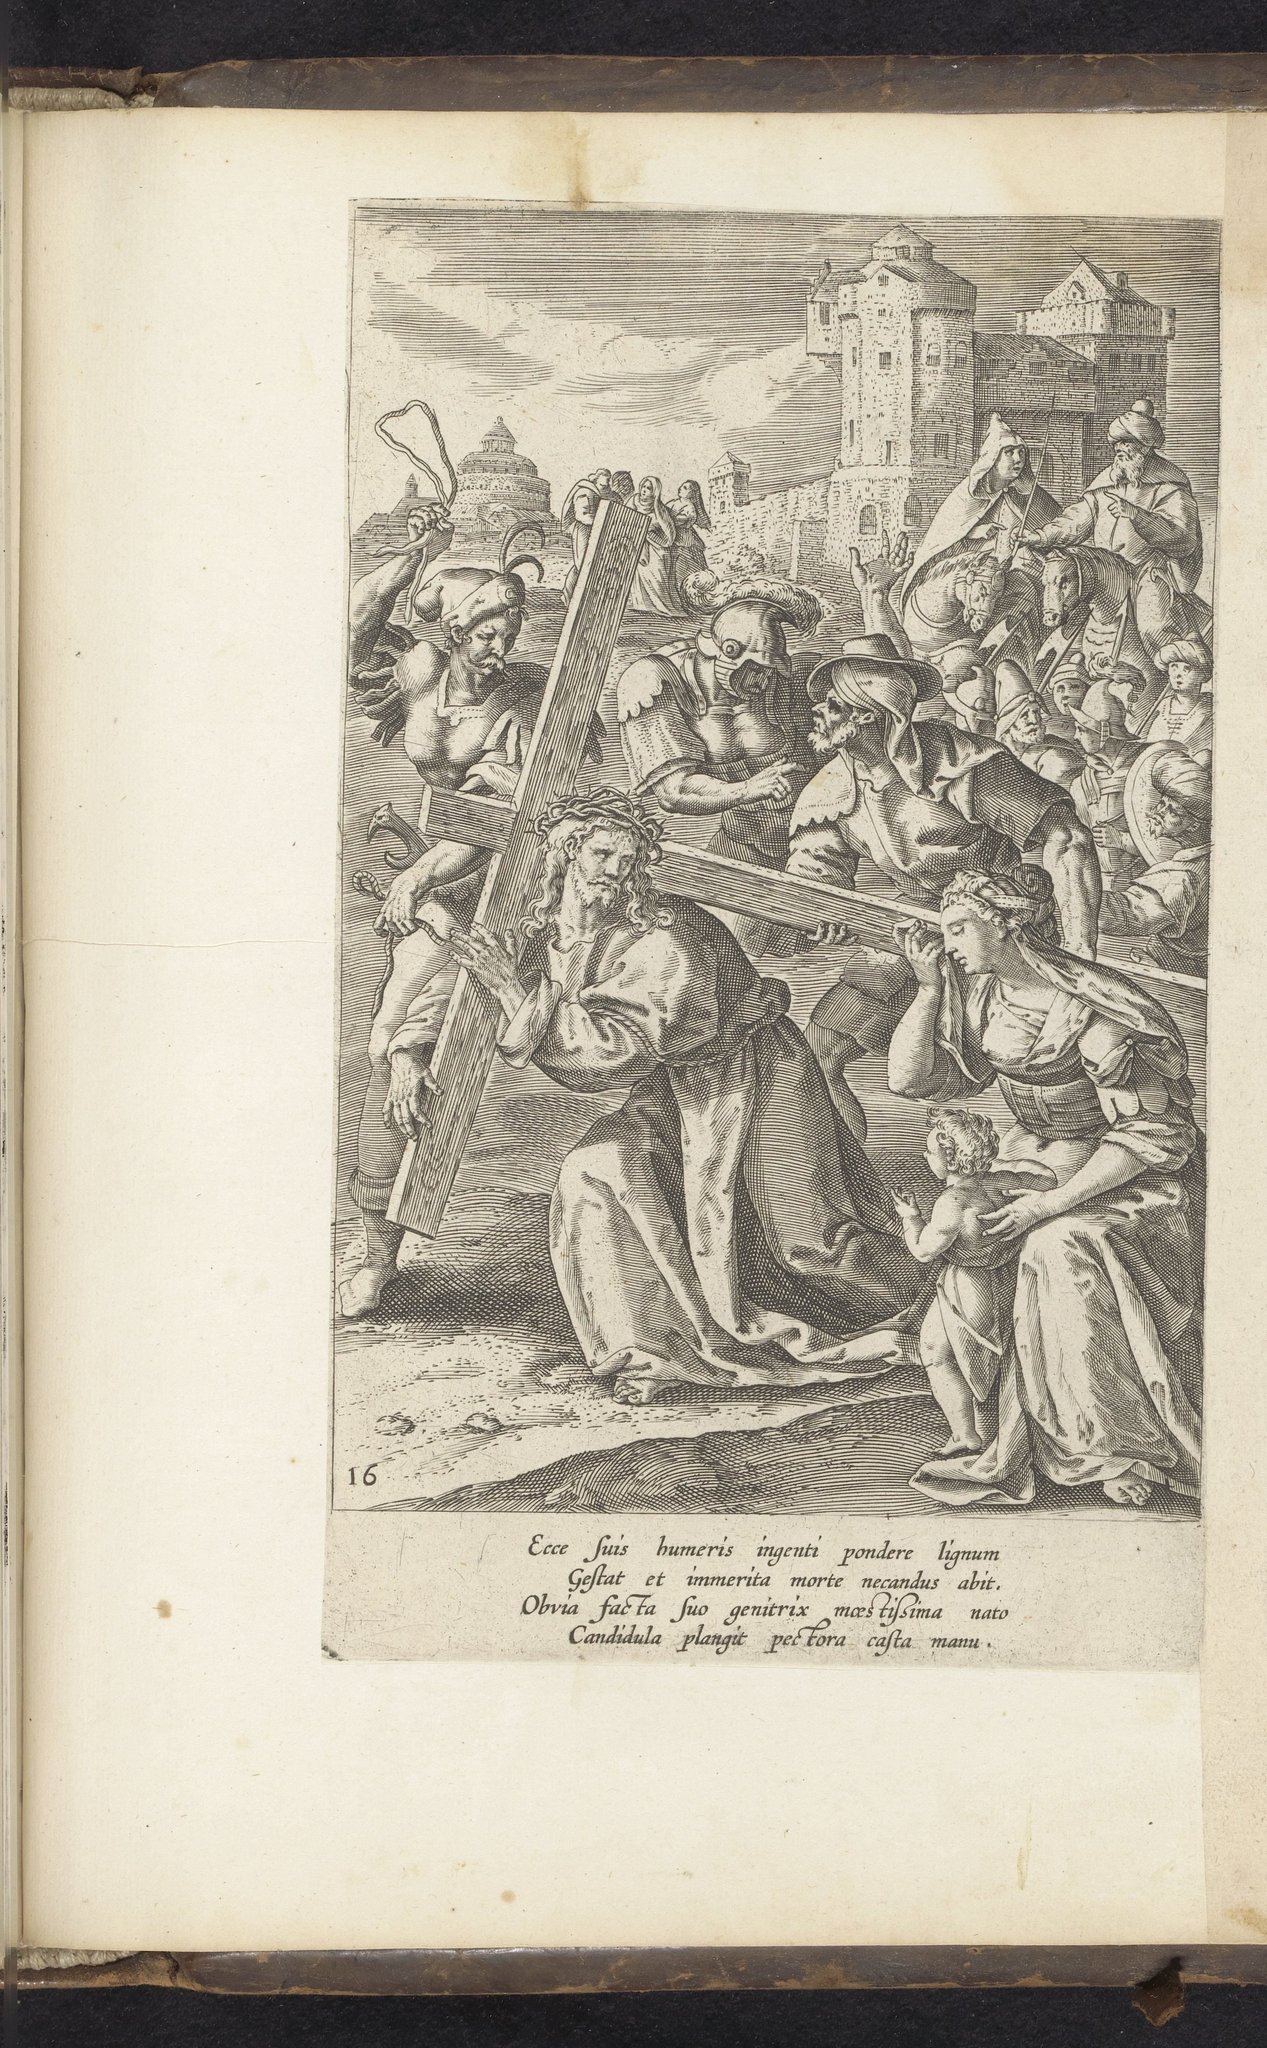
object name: print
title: Passie van Christus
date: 1585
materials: paper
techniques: engraving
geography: amsterdam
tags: christ collapsing ~ carrying of the cross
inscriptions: number: ‘140’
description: Christus valt tijdens het dragen van zijn kruis naar Golgota. Simon van Cyrene helpt hem met het dragen van het kruis. Een Romeinse soldaat spoort hem aan om op te staan. Een vrouw en haar kleine kind kijken bedroefd toe. Onder de voorstelling een vierregelig vers in het Latijn. Deze prent maakt deel uit van een album.